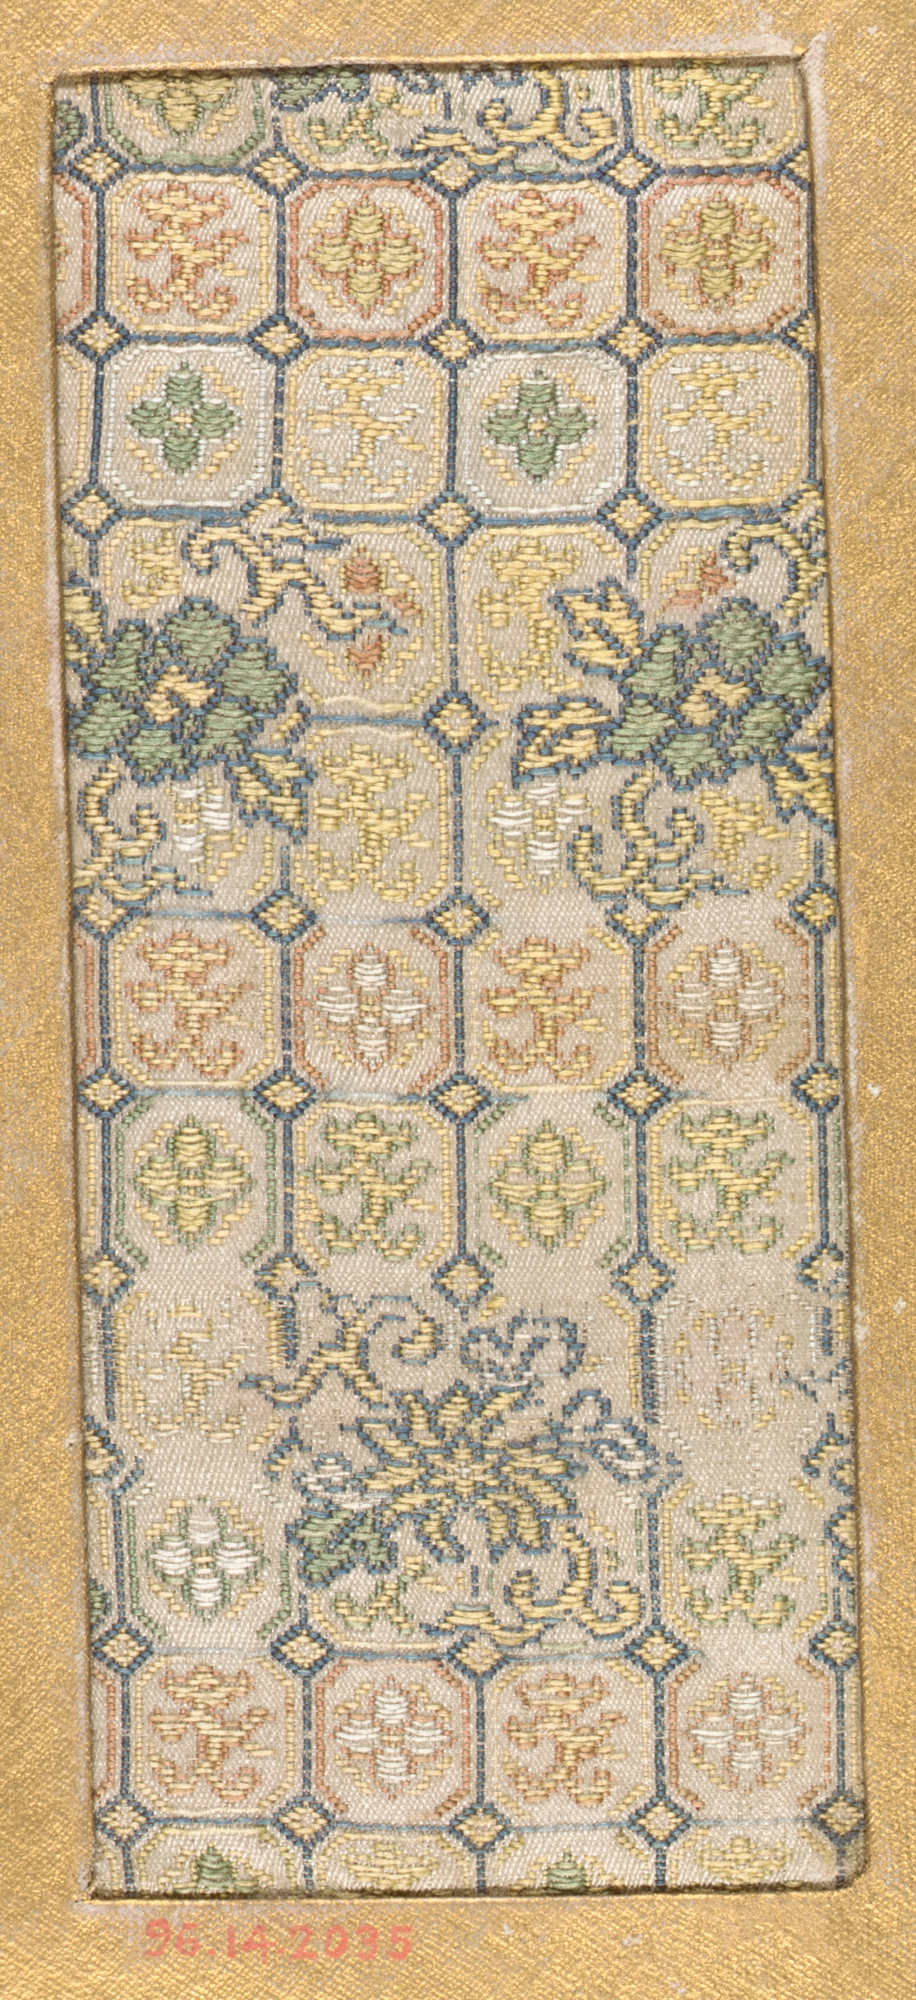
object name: piece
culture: japanese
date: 1701-1900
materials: silk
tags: flowers